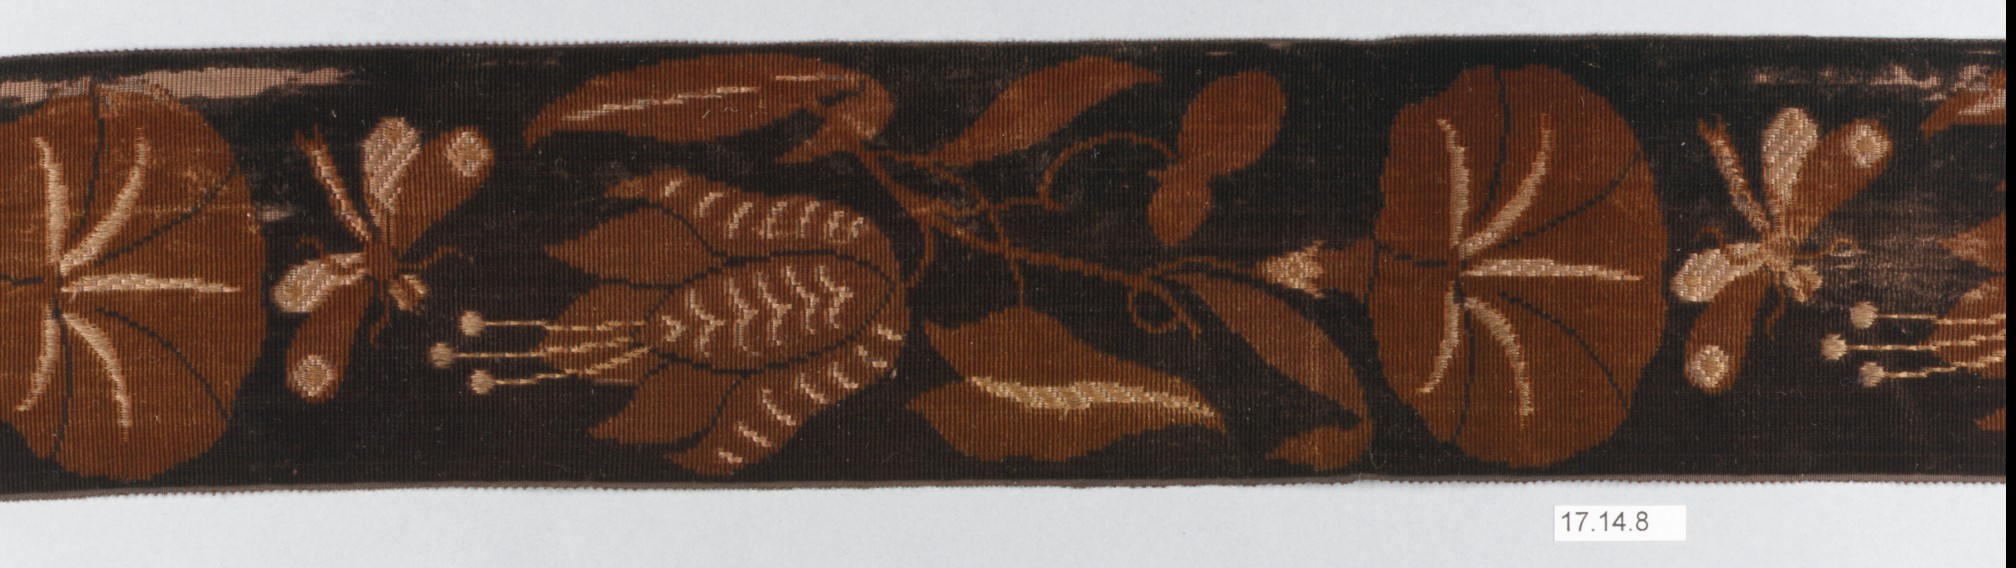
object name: ribbon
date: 1701-1800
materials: velvet